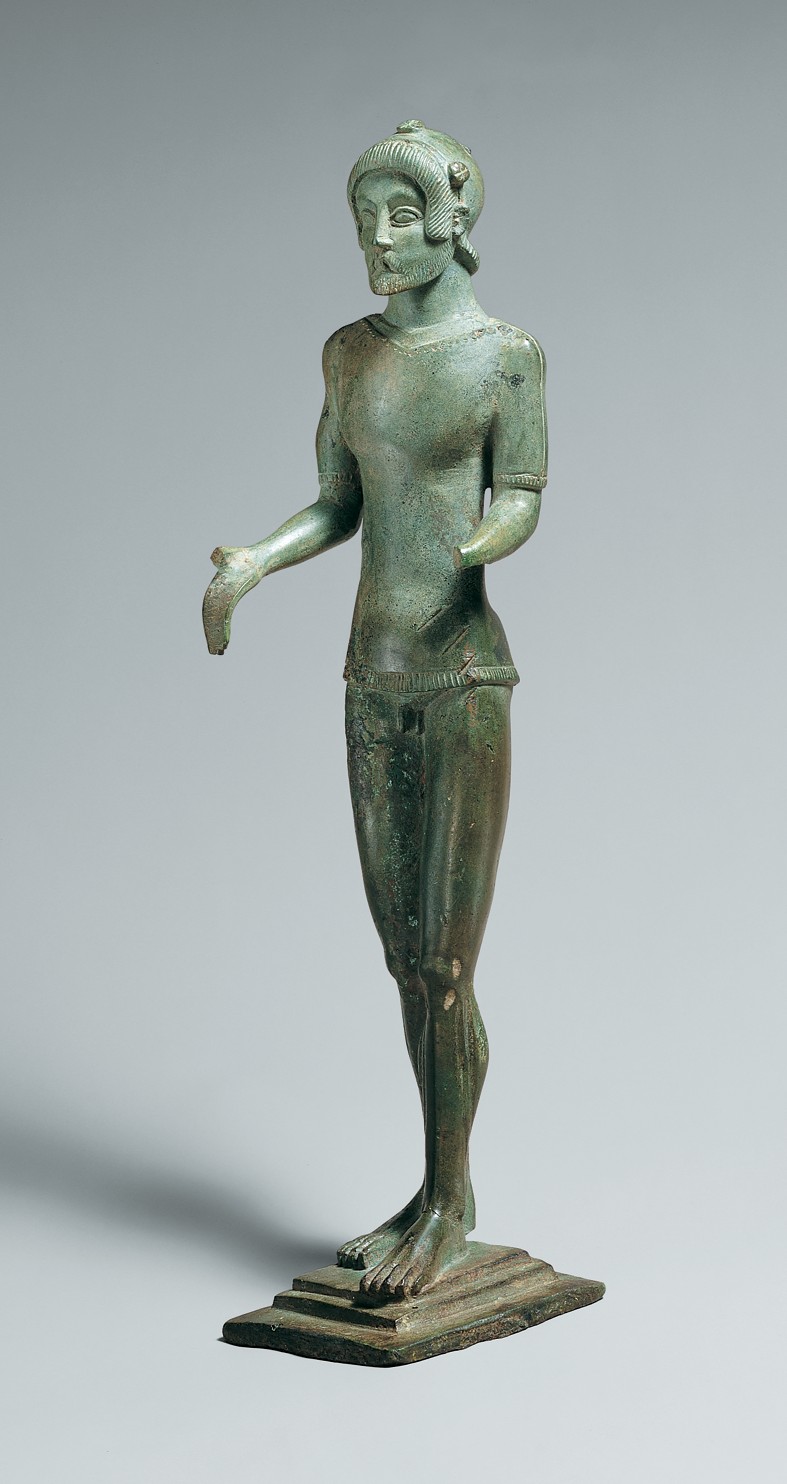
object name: statuette of a bearded man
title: Bronze statuette of a standing male figure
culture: campanian or south italian greek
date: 500-450 BCE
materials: bronze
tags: men